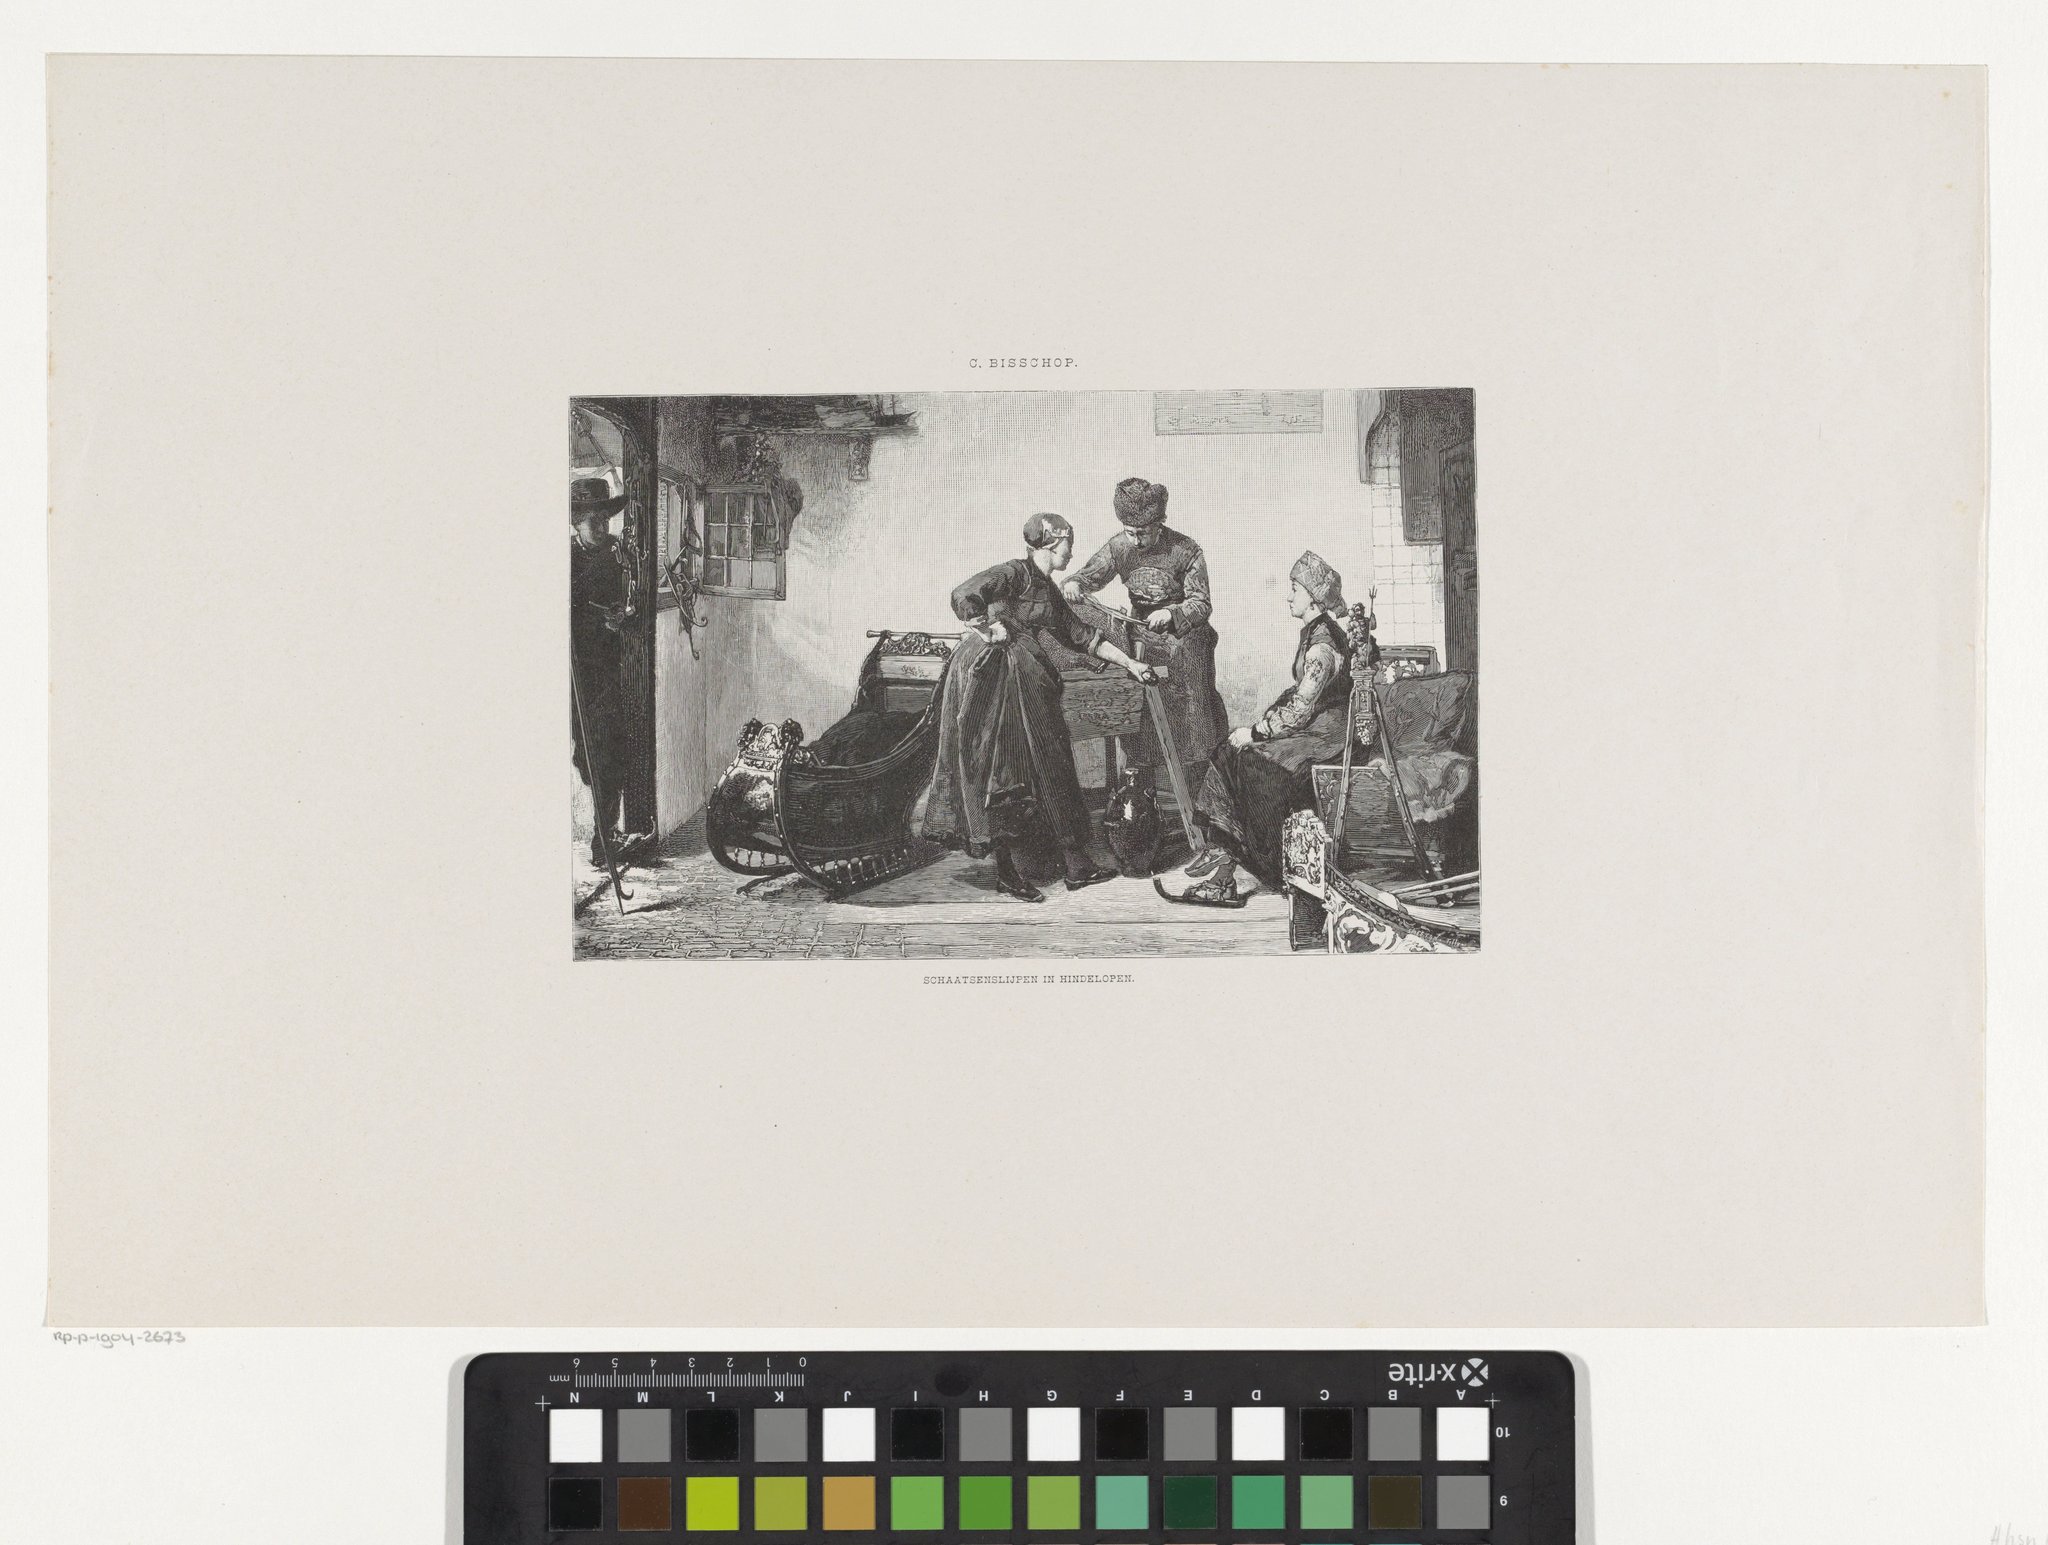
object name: print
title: Schaatsenslijpen in Hindelopen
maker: christoffel bisschop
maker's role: draughtsman, print maker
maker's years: 1828-1904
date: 1874-1888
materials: paper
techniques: engraving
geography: paris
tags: sharpening, grinding (industrial processes), skates (winter sports)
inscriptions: collector's mark: Lugt 2228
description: Een man en een vrouw slijpen de schaats van een andere vrouw die, met nog één schaats aan, in een stoel zit te wachten. Links komt een man met schaatsen aan binnen lopen.